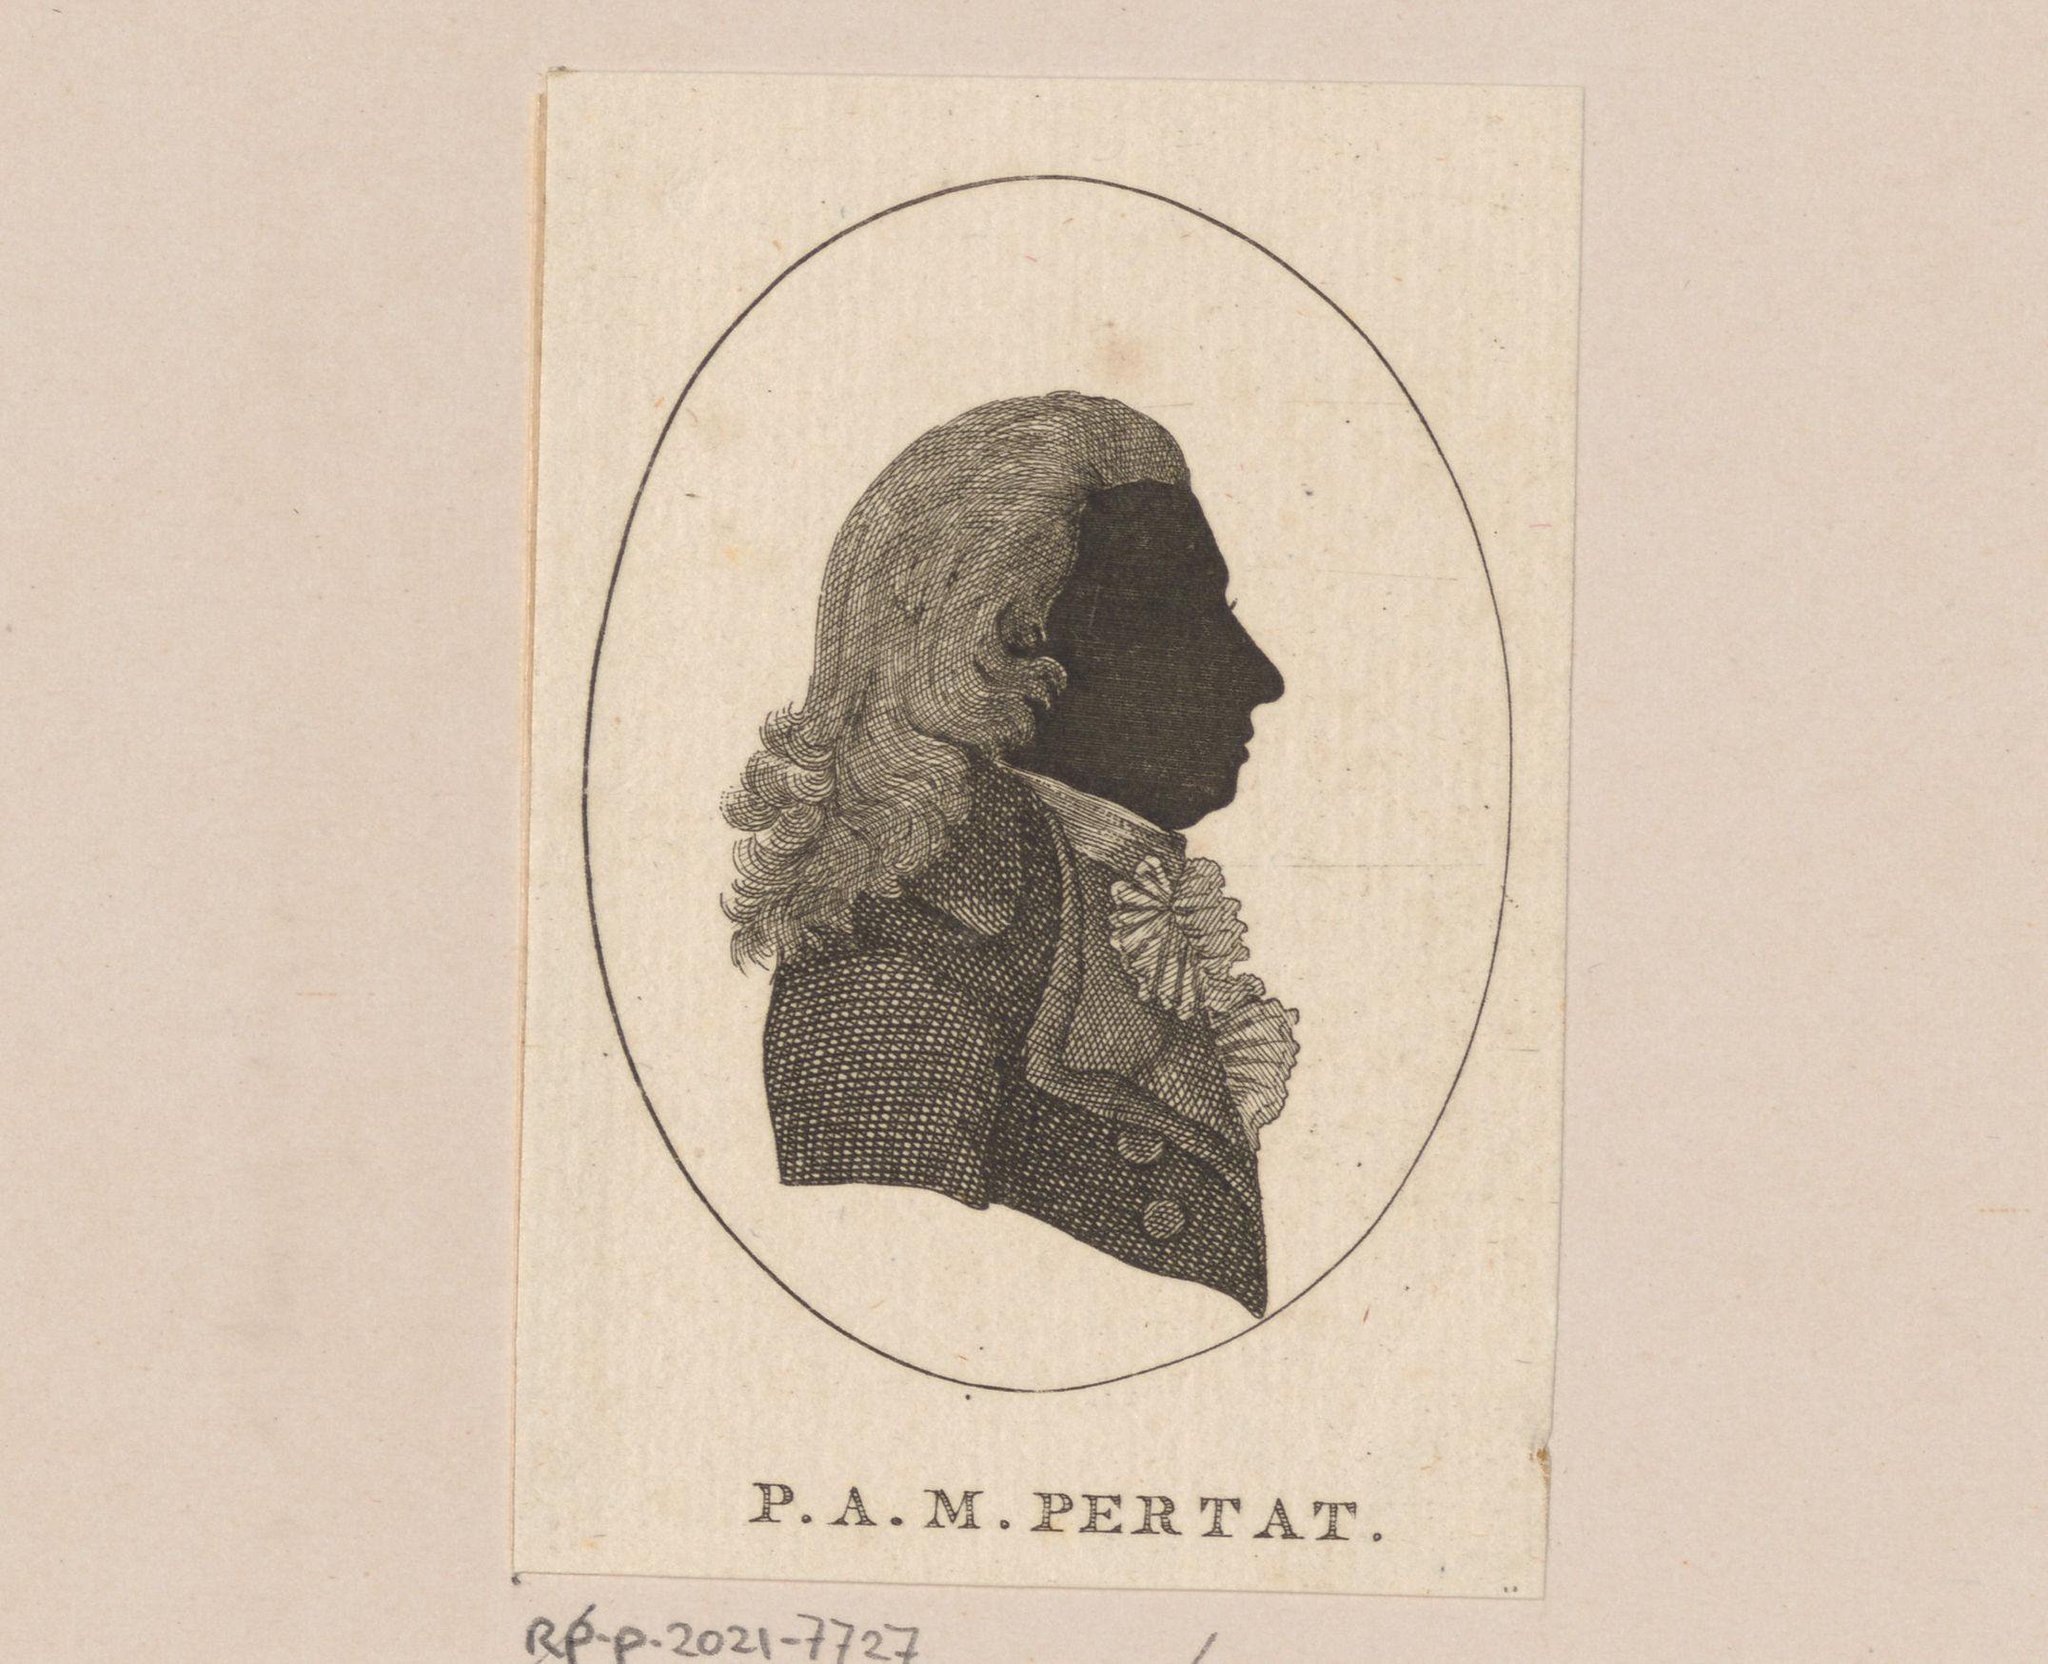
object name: print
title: Portret van Petrus Matthaeus Pertat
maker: Anonymous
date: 1799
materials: paper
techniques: engraving, etching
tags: amsterdam, politician, adult man, historical persons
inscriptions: inscription: ‘R.L.’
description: Prent mogelijk uit: Rogge, Cornelis. Geschiedenis der staatsregeling, voor het Bataafsche volk. Amsterdam: Johannes Allart, 1799.